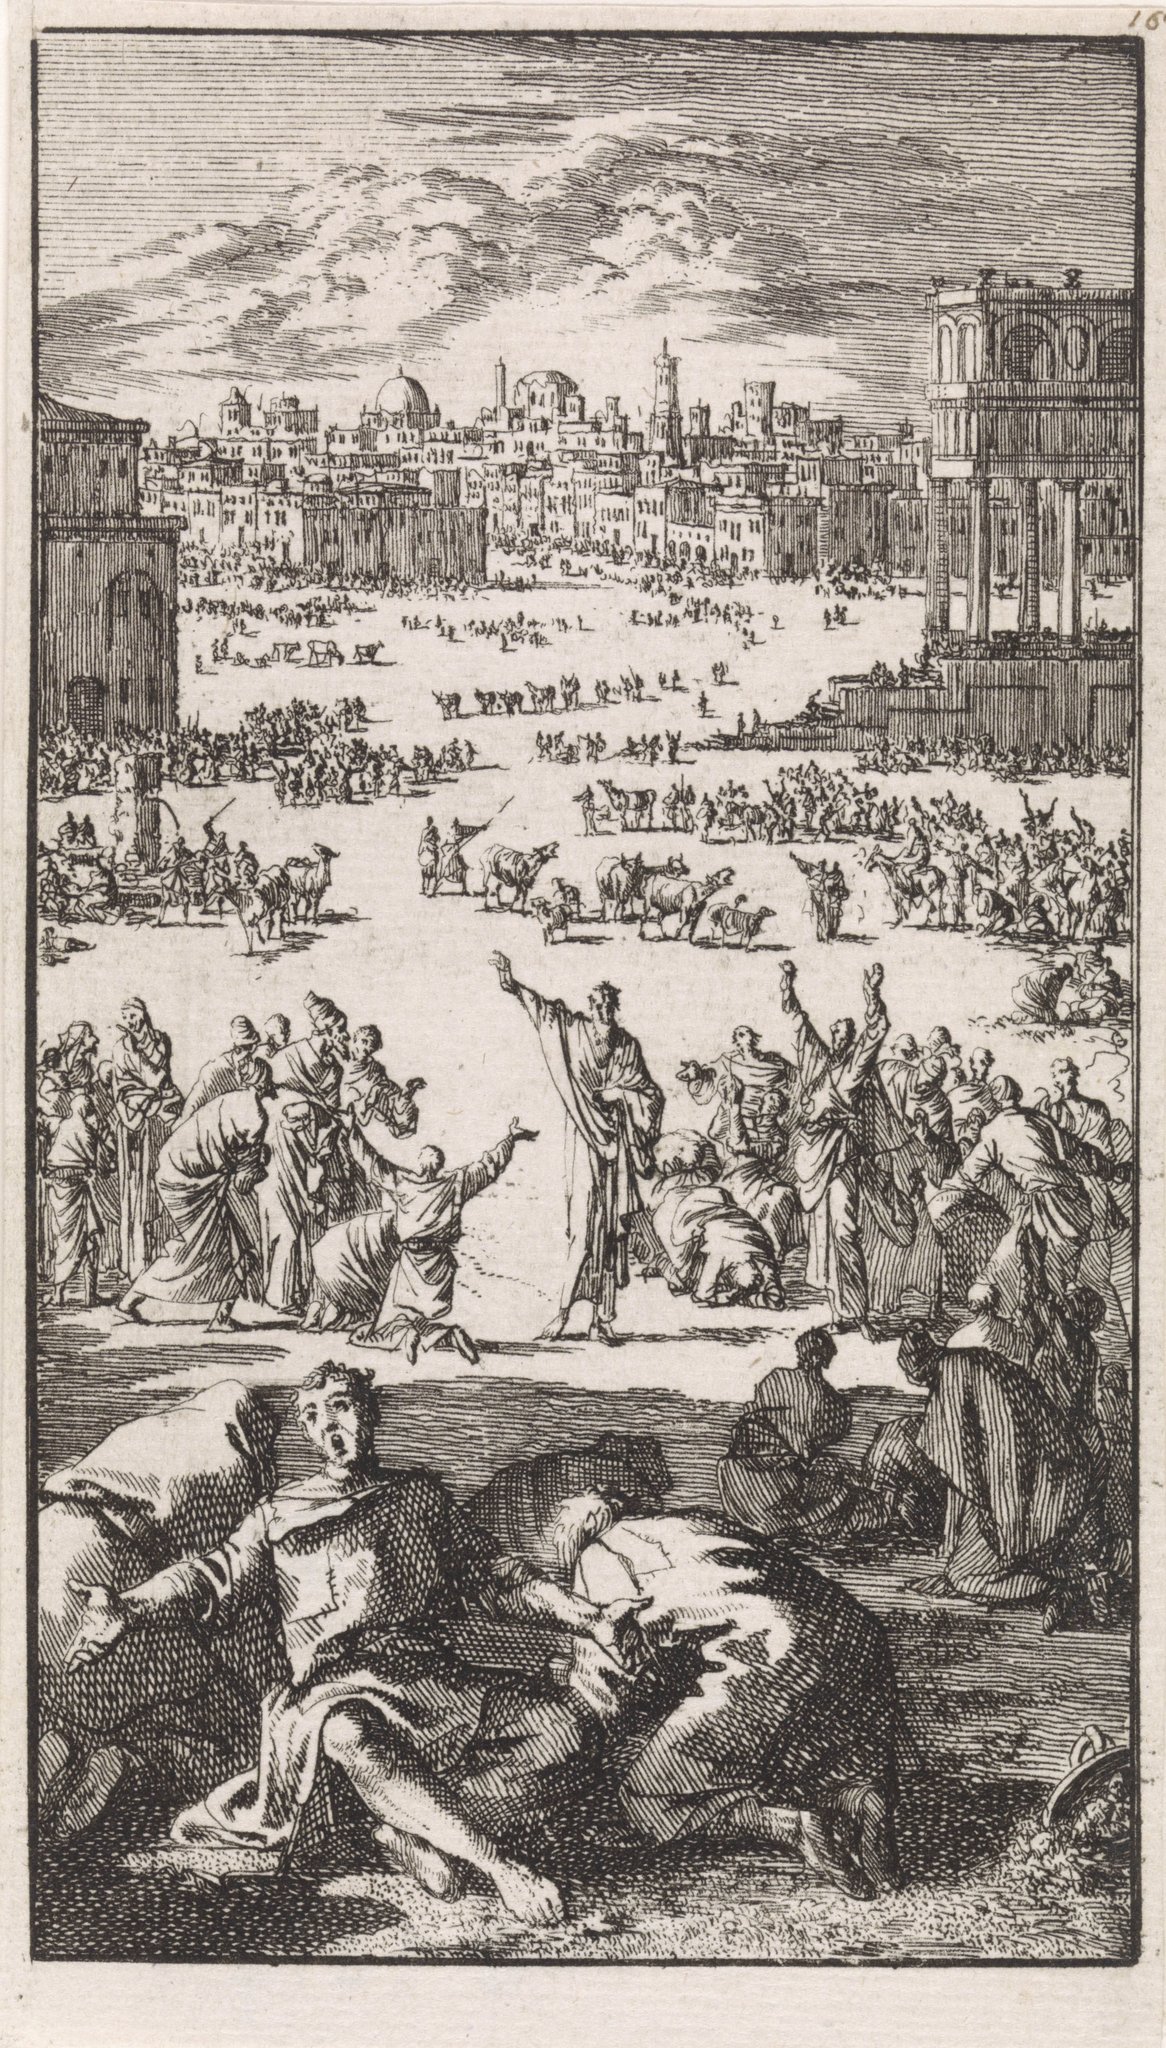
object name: print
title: Jona voorspelt de ondergang van Nineve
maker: jan luyken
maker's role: draughtsman, print maker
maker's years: 1649-1712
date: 1712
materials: paper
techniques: etching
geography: amsterdam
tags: when jonah arrives in the city of nineveh he foretells its destruction in forty days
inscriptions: collector's mark: Lugt 2228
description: Proefdruk van illustratie voor: Luyken, Jan. Bybel printen. Amsterdam: Pieter Arentsz. II (wed.) en Cornelis van der Sys, 1712, p. 17.